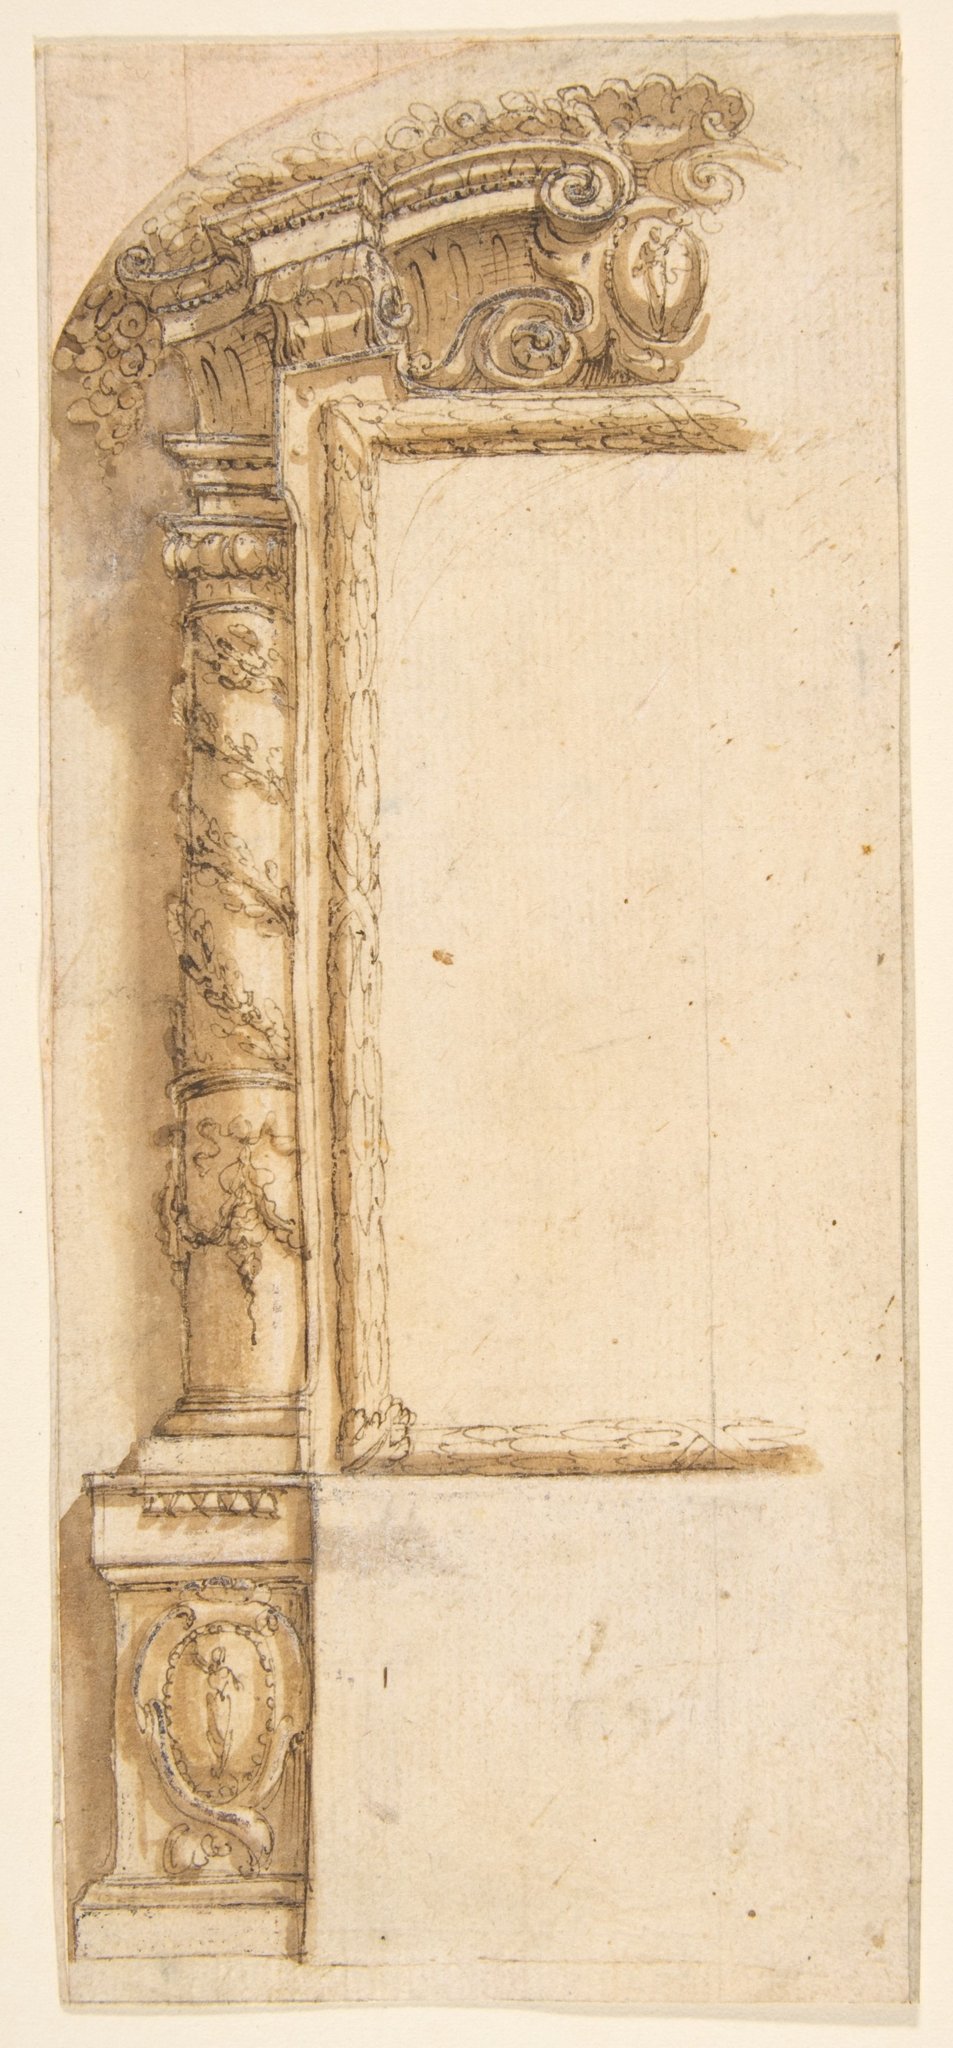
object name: drawing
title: Left Half Design for an Architectural Project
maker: mauro antonio tesi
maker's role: artist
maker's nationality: italian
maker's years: 1730-1766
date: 1730-1766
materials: ink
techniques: brush, pen, wash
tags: architecture